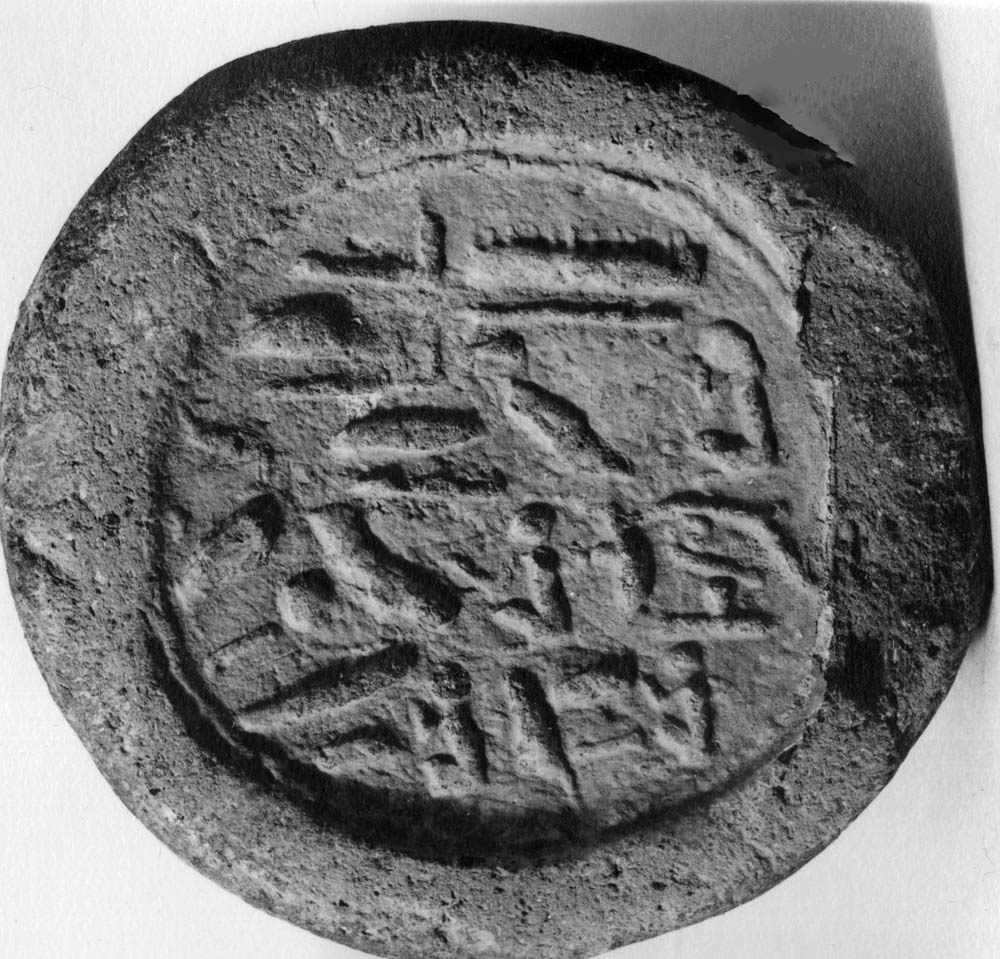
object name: cone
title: Funerary Cone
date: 1550-1295 BCE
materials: pottery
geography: egypt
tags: hieroglyphs